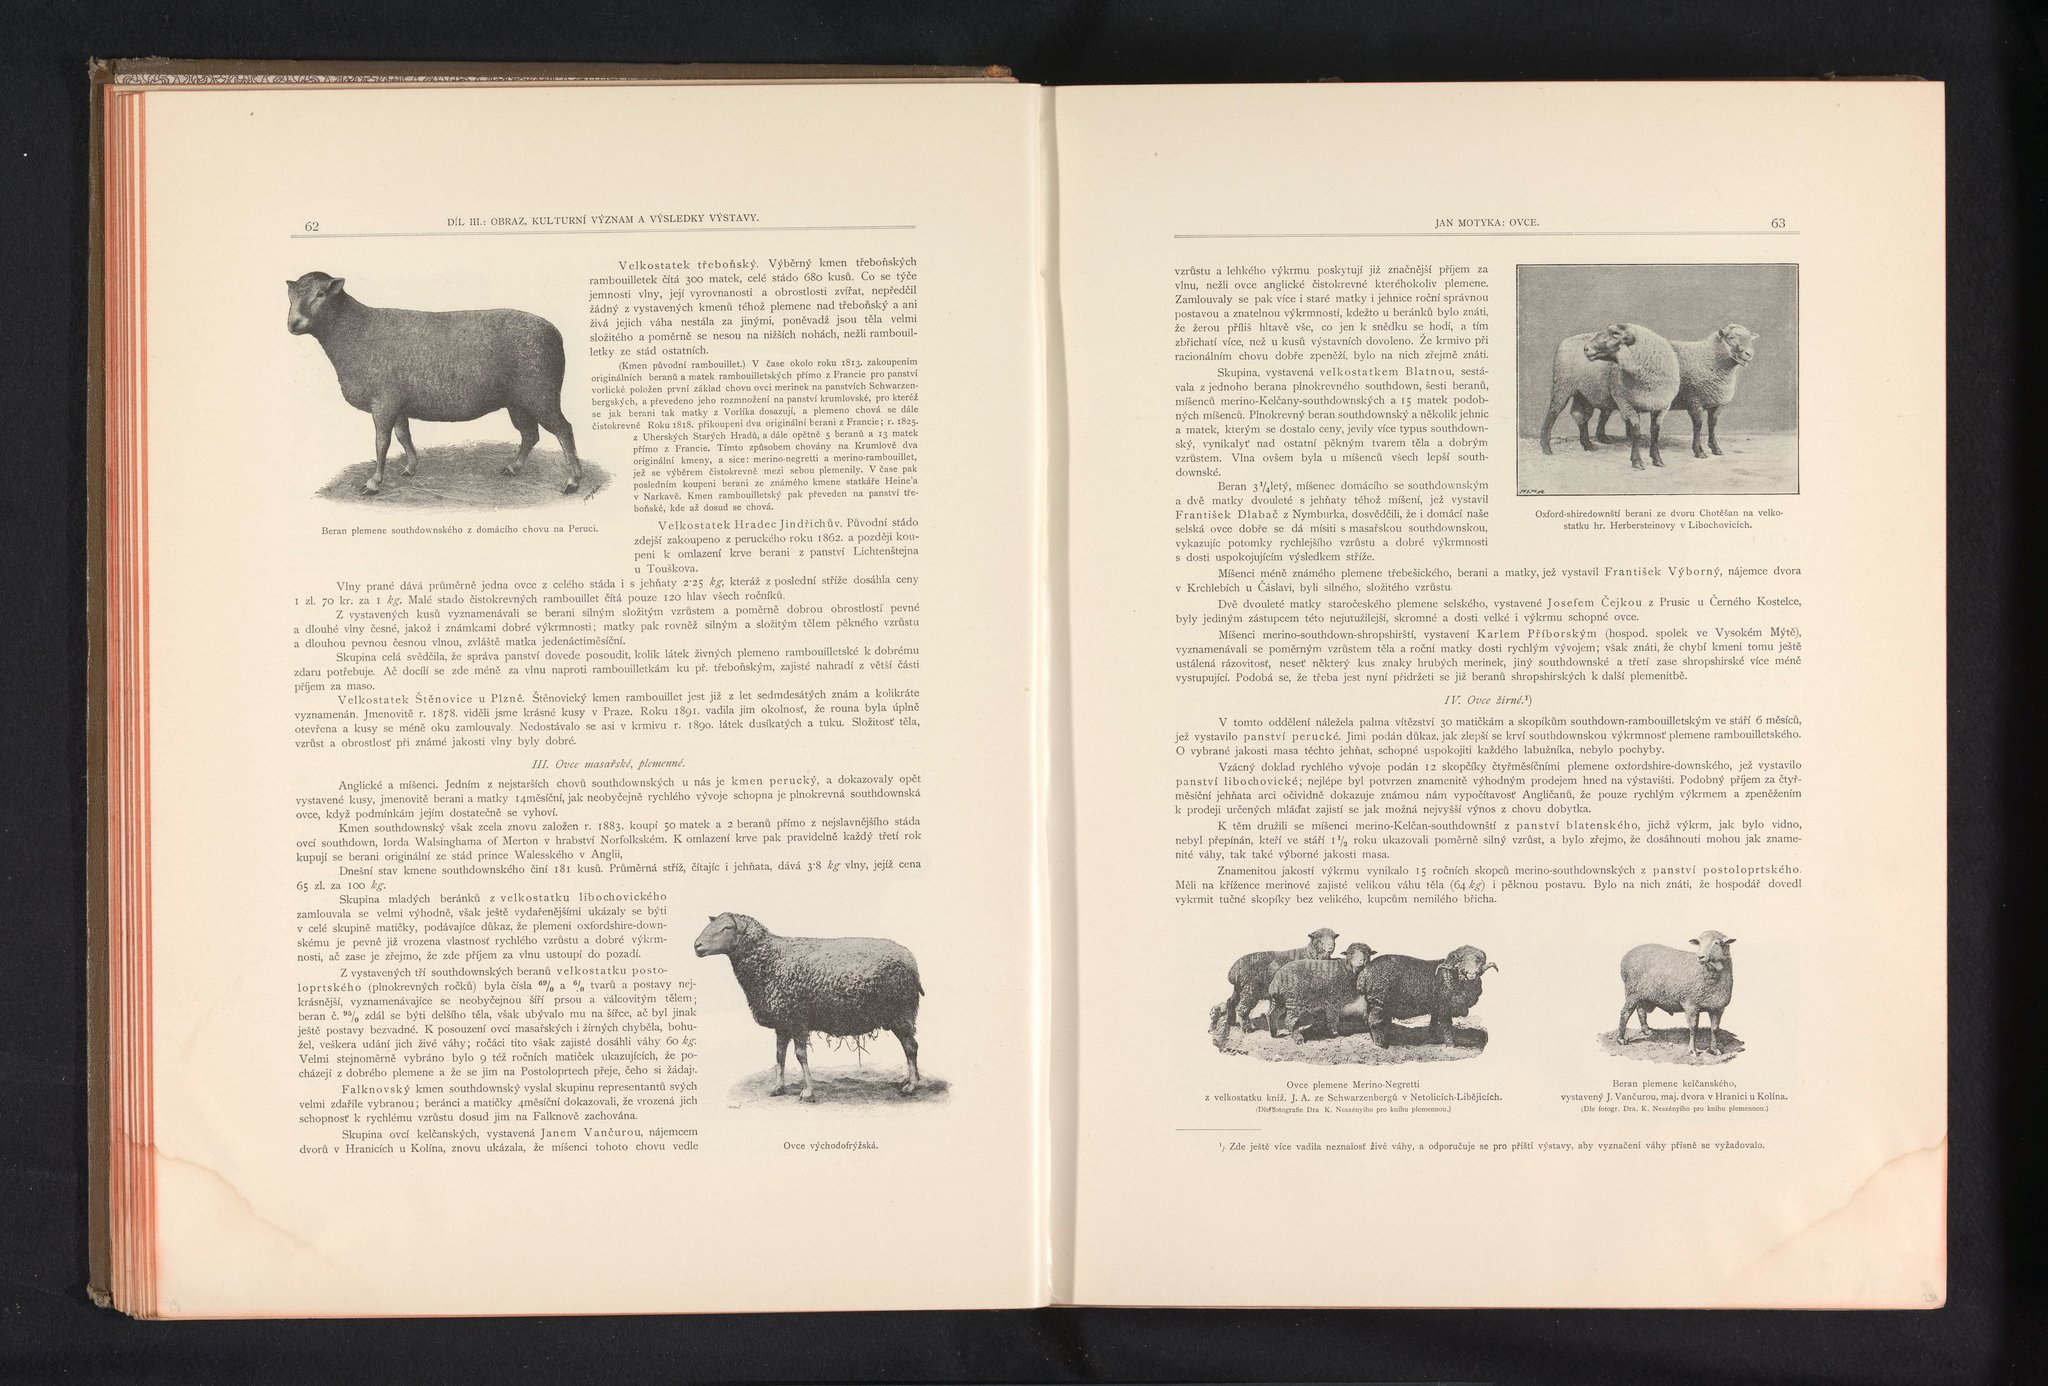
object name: photomechanical print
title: Drie schapenrassen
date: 1891-1895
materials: paper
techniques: autotype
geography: prague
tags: sheep